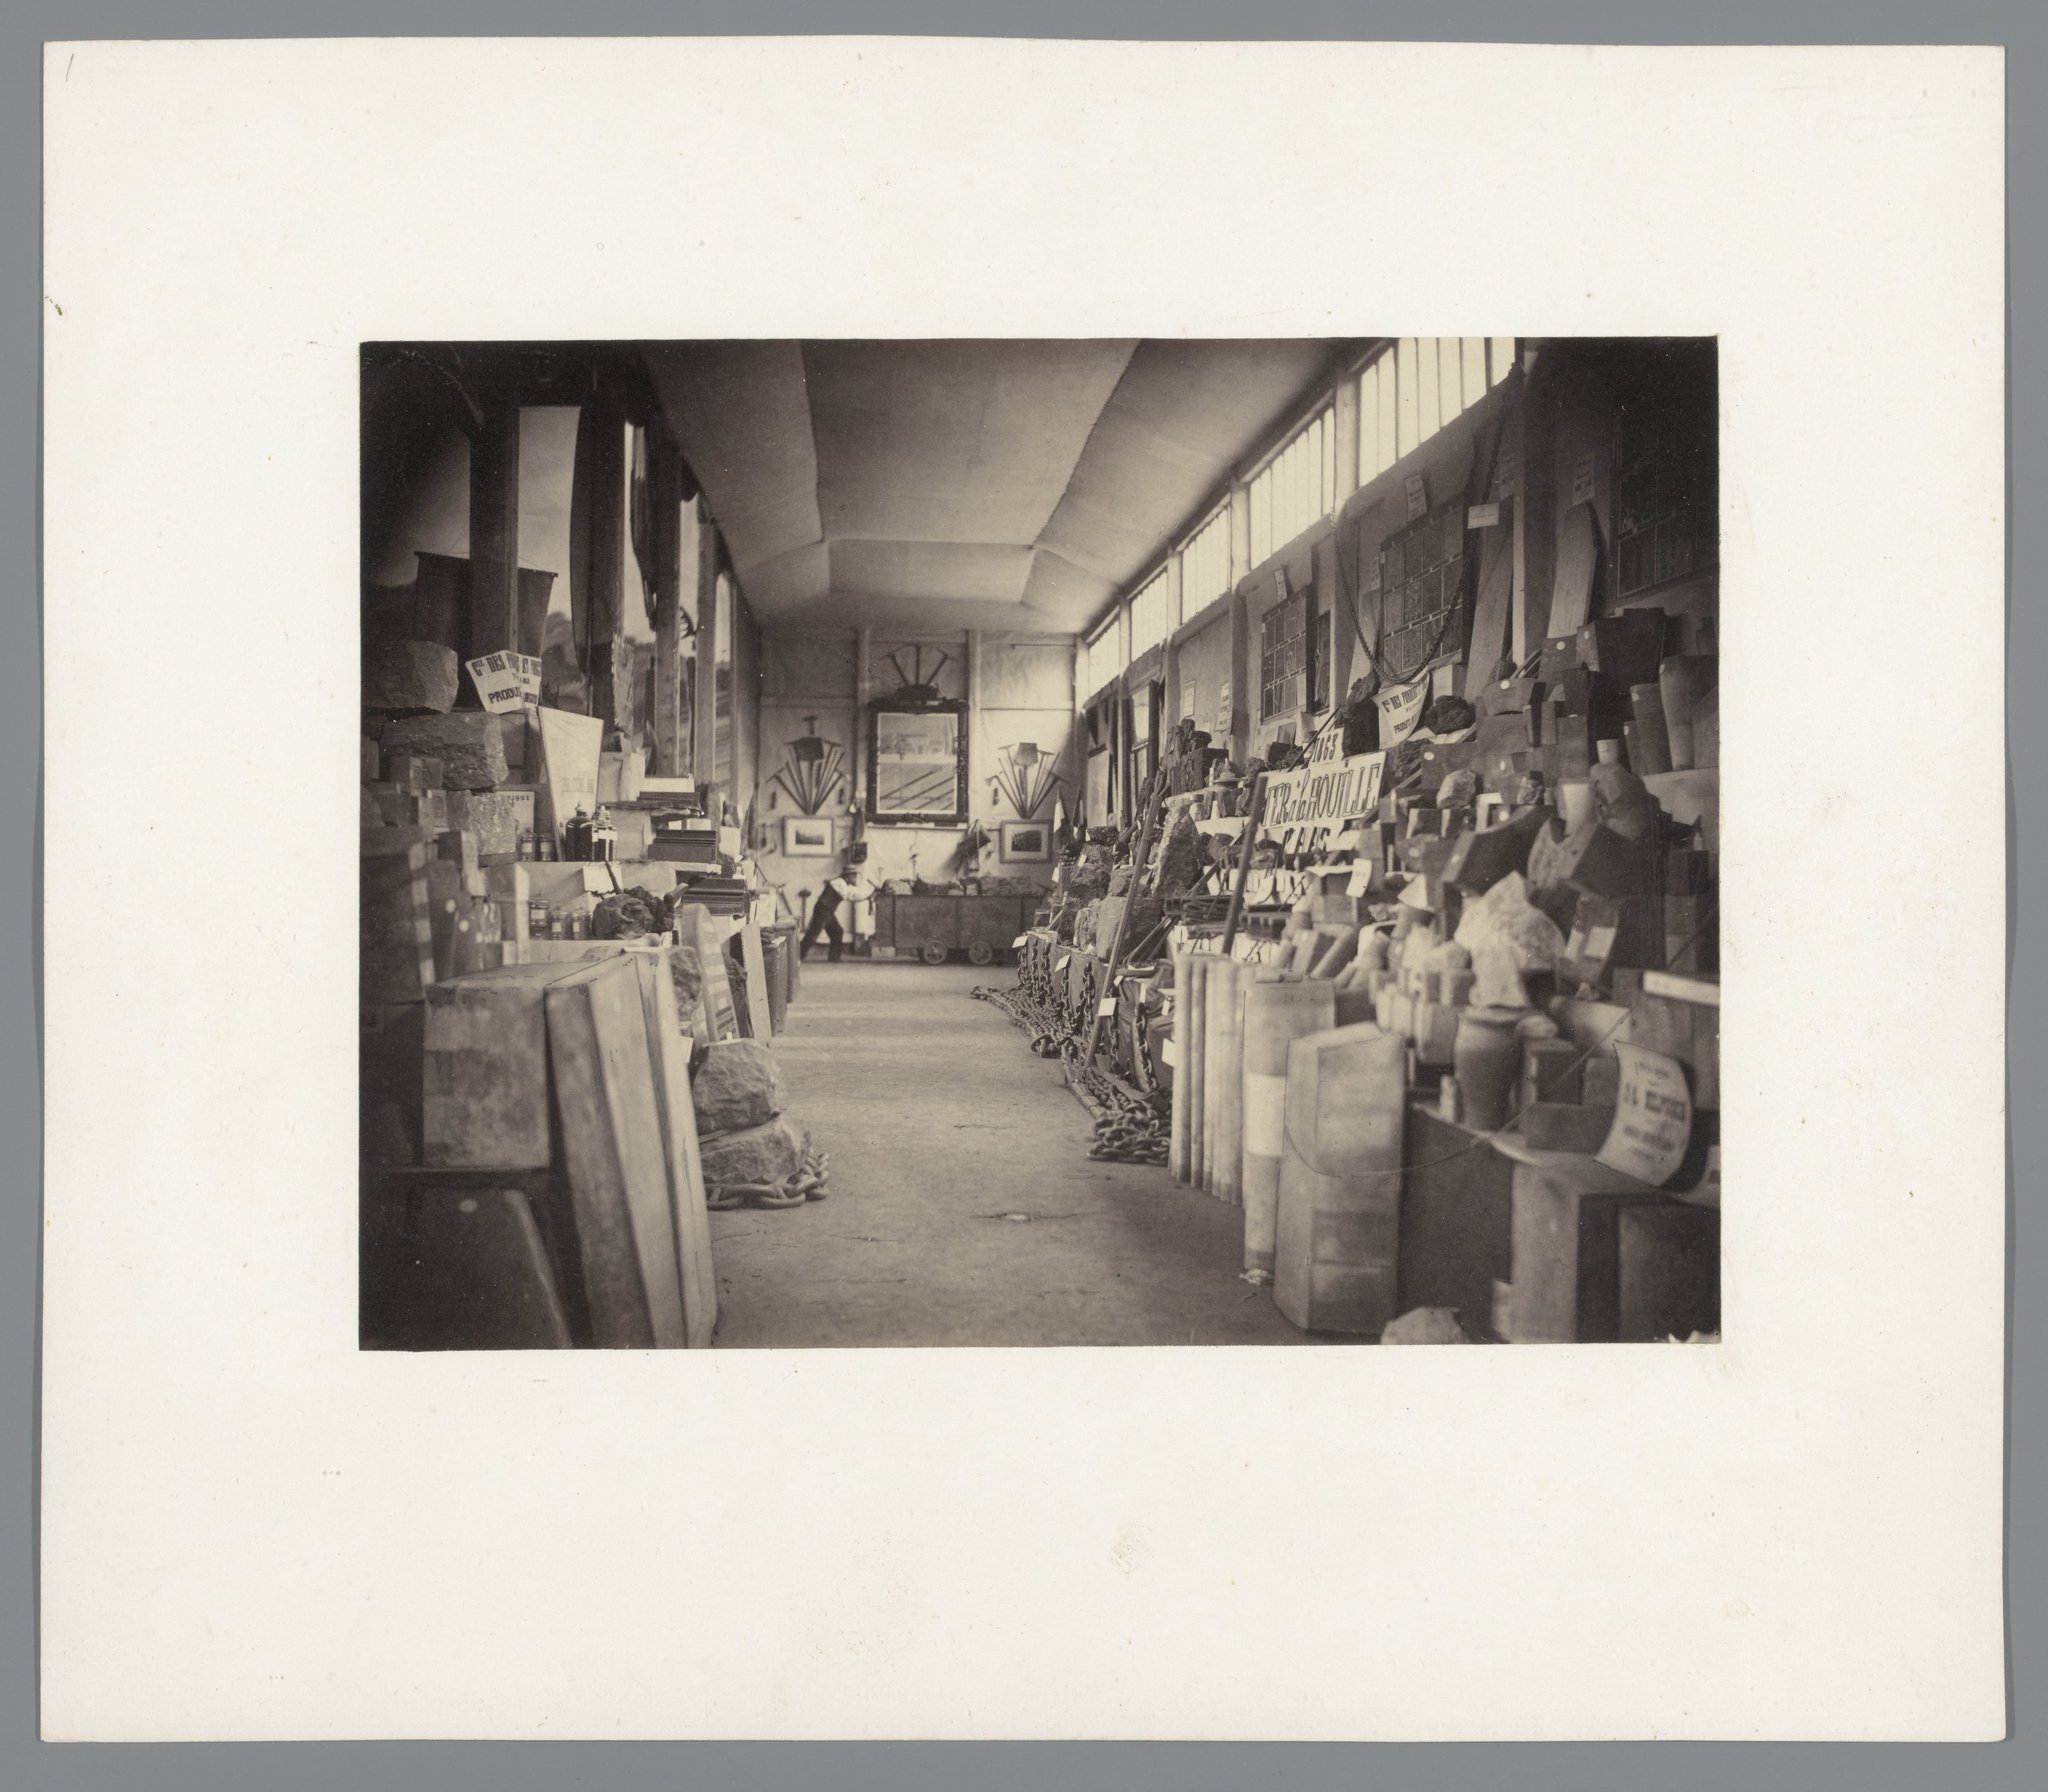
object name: photograph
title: Galerie de Minéralogie op het Concours régional in Nîmes, 1863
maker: Anonymous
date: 1863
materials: paper, photographic support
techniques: albumen print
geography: nîmes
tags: trade exhibition, industries fair, (annual) fair, trade fair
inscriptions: inscription: ‘Exposition de Nîmes. galerie de mineralogy bas coté à l'ouest de la grande nef’, inscription: ‘Galerie de Minéralogie. Exposition de Mîmes, 1863’